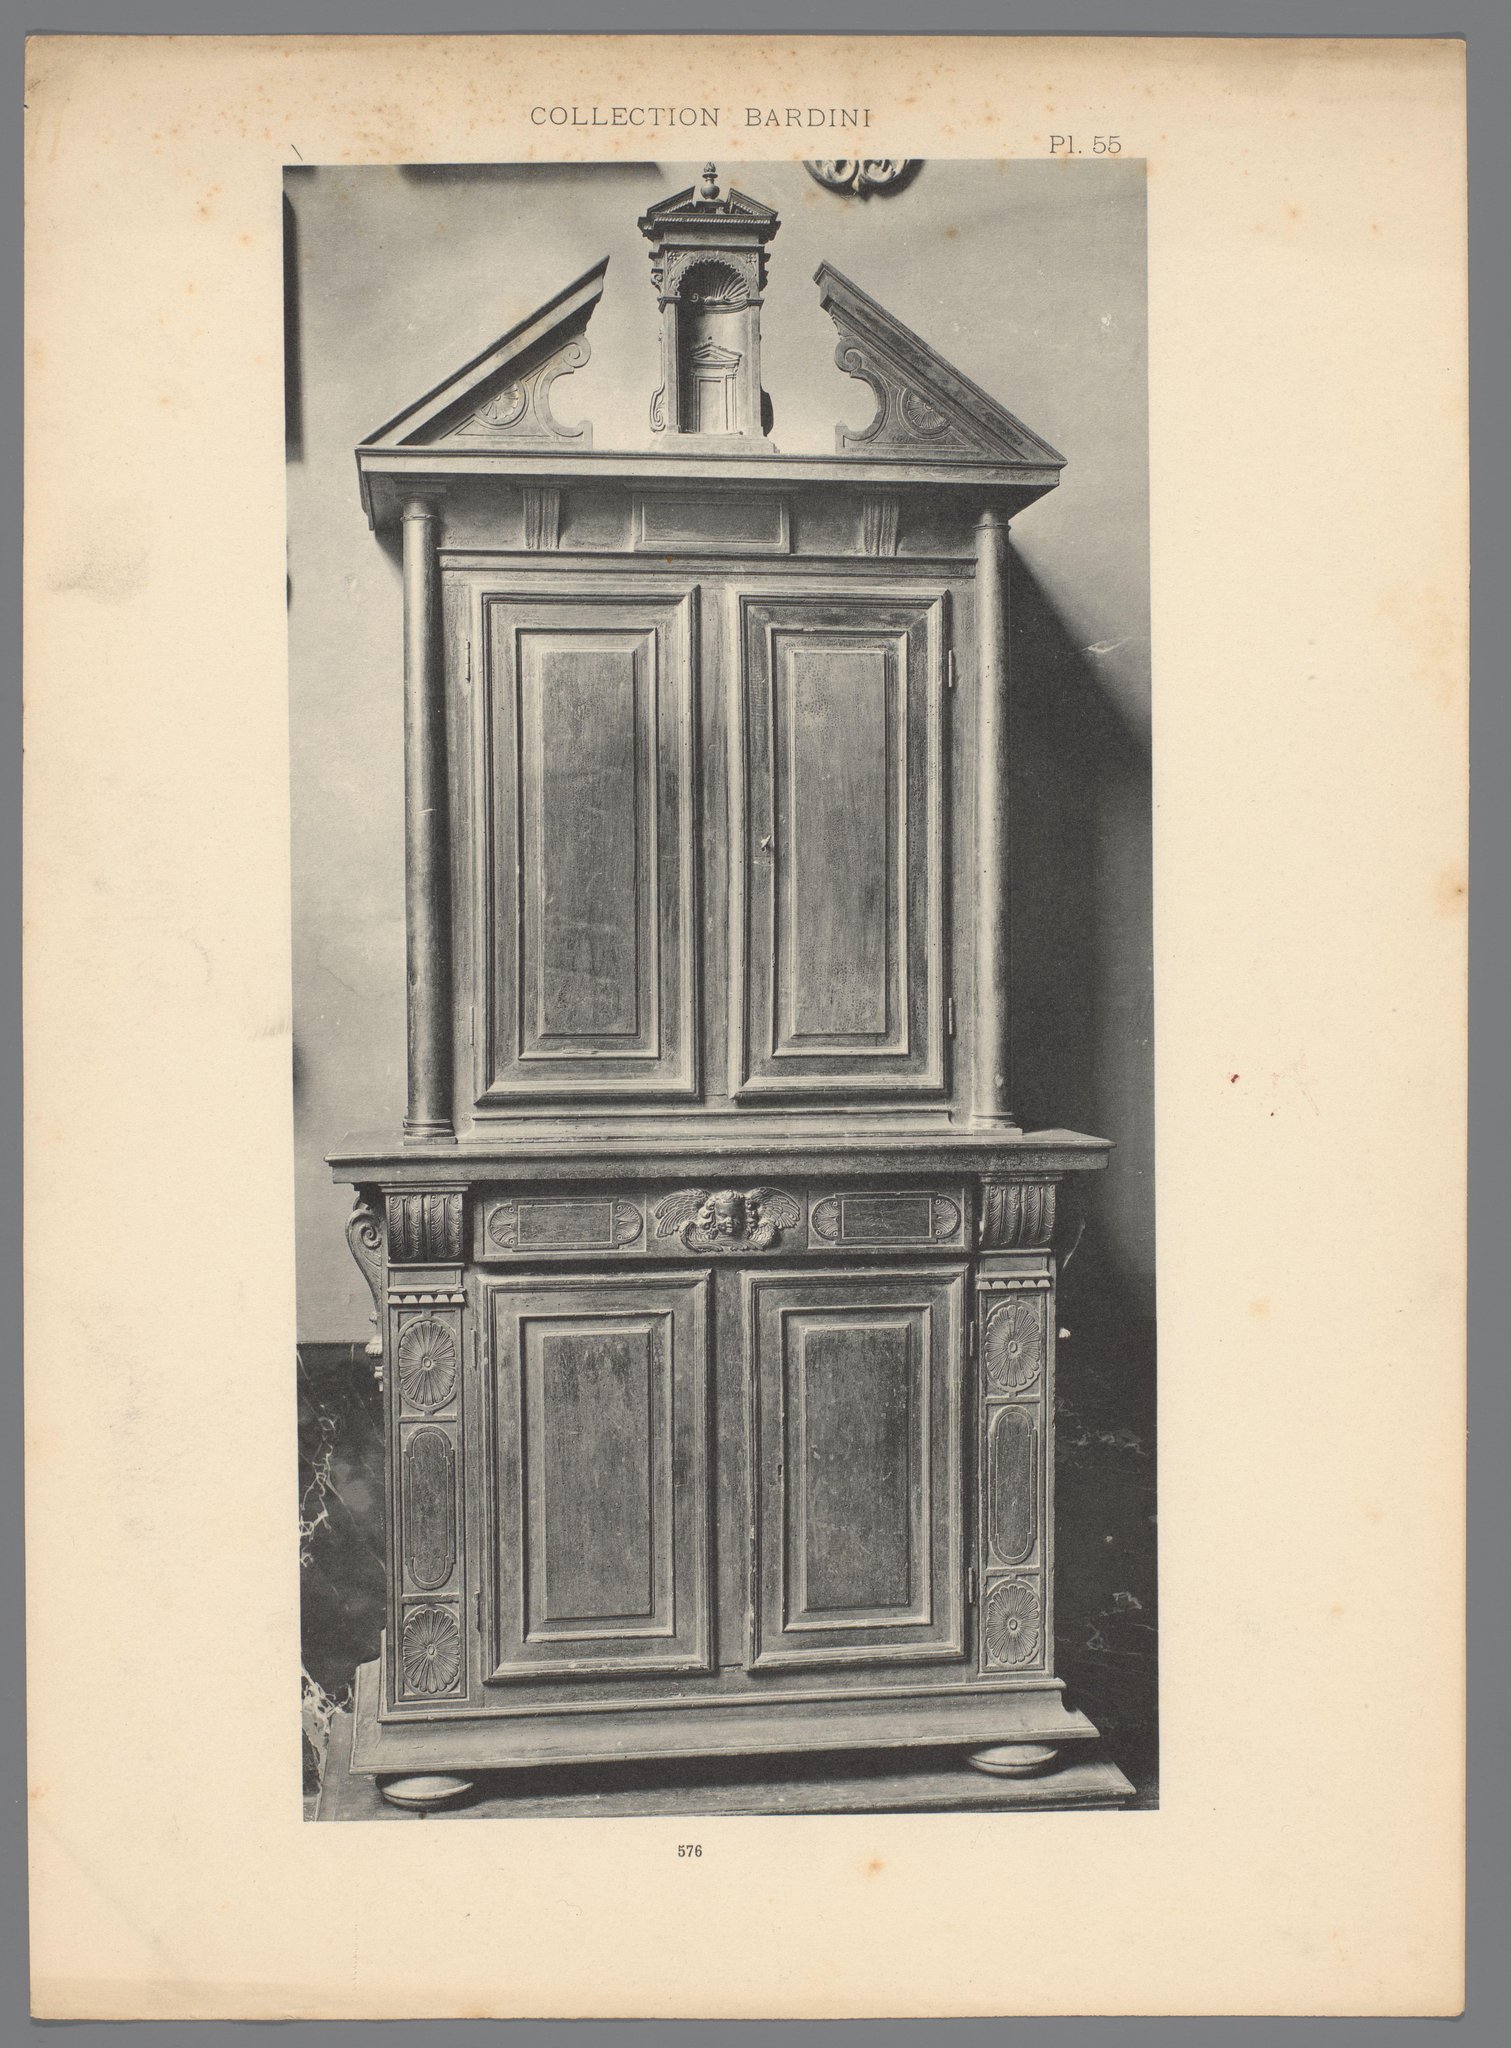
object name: photomechanical print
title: Gedecoreerd kabinet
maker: Anonymous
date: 1875-1930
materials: paper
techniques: photograph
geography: florence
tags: ornamental cupboard (+ wood and other phytogenic material)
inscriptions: number: ‘Pl. 55’